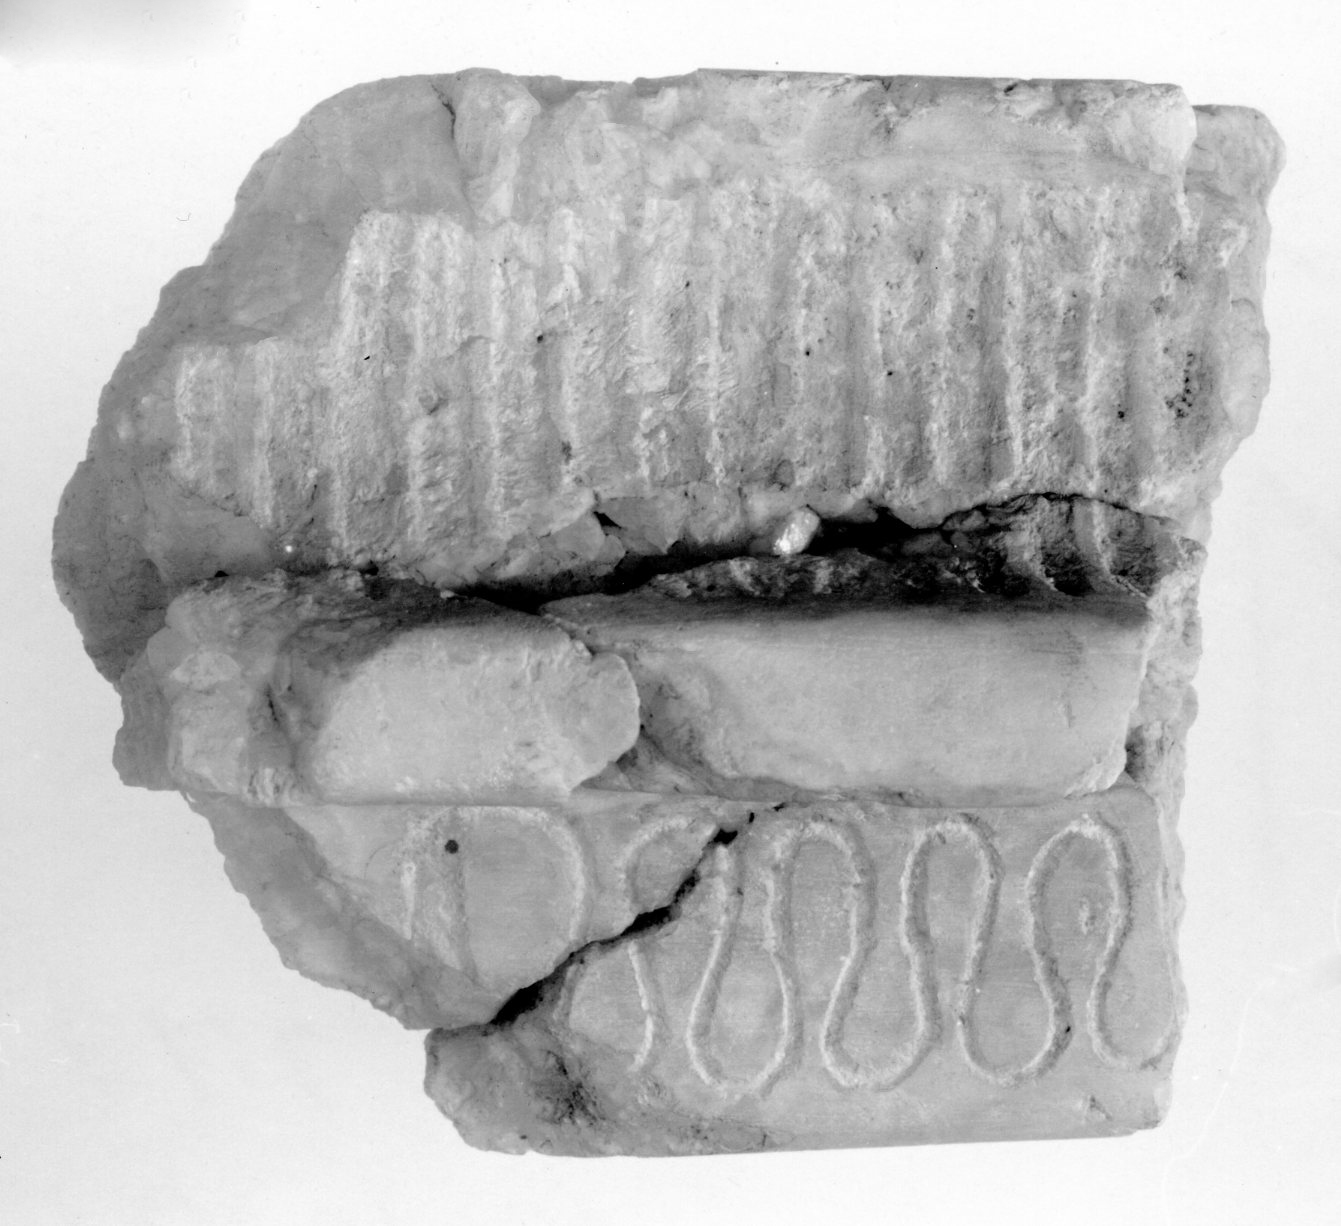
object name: canopic chest fragment, siptah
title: Canopic Chest Lid Fragment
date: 1194-1188 BCE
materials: stone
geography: egypt